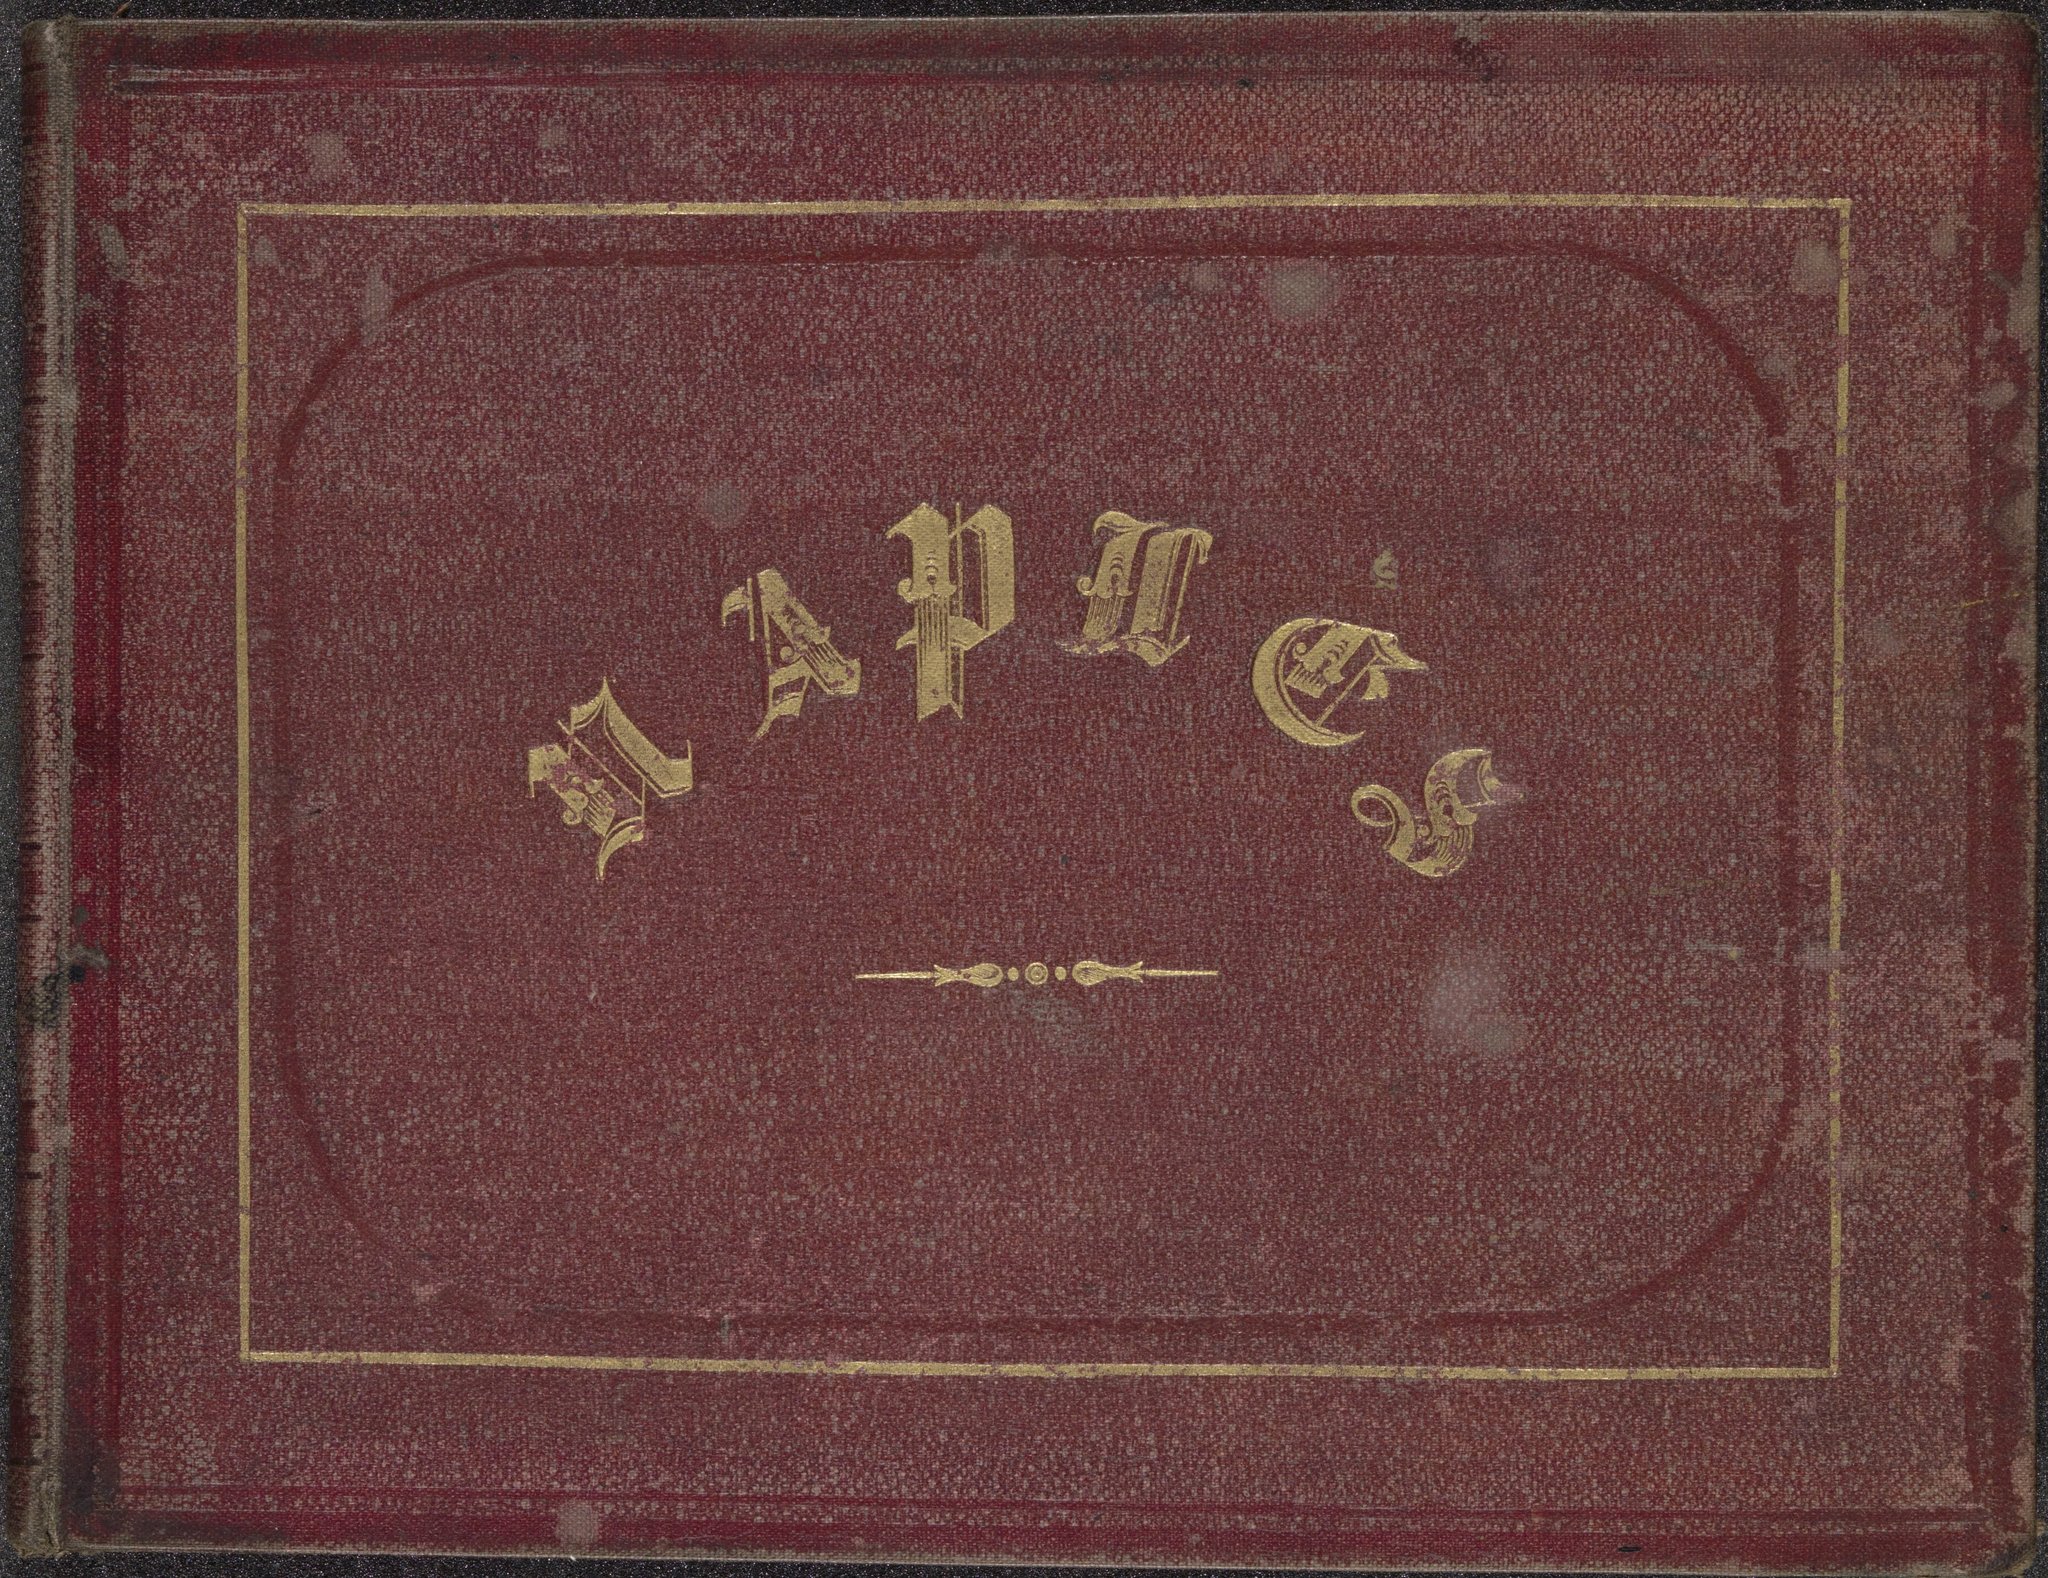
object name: scrapbook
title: Naples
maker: roberto rive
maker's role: fotograaf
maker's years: 1825-1868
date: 1860-1900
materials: cardboard, linen, paper, photographic support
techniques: albumen print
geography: italy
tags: travelling; tourism, prospect of city, town panorama, silhouette of city, naples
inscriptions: name: ‘Theo Thissen’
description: Fotoalbum in rode linnen band. Op het voorplat de titel in gouddruk en in reliëf. De schutbladen zijn van beige papier. Het album bevat 25 bladen met evenveel afdrukken. Het zijn opnames van bezienswaardigheden in Napels en het nabijgelegen Ischia, Capri, Sorrento en Amalfi. Afgebeeld zijn onder meer stadsgezichten, landschappen, kusten, pleinen en gebouwen waaronder de San Francesco di Paola, de Piazza dei Martiri, het Koninklijk Paleis, de Villa Nazionale en de Venustempel.